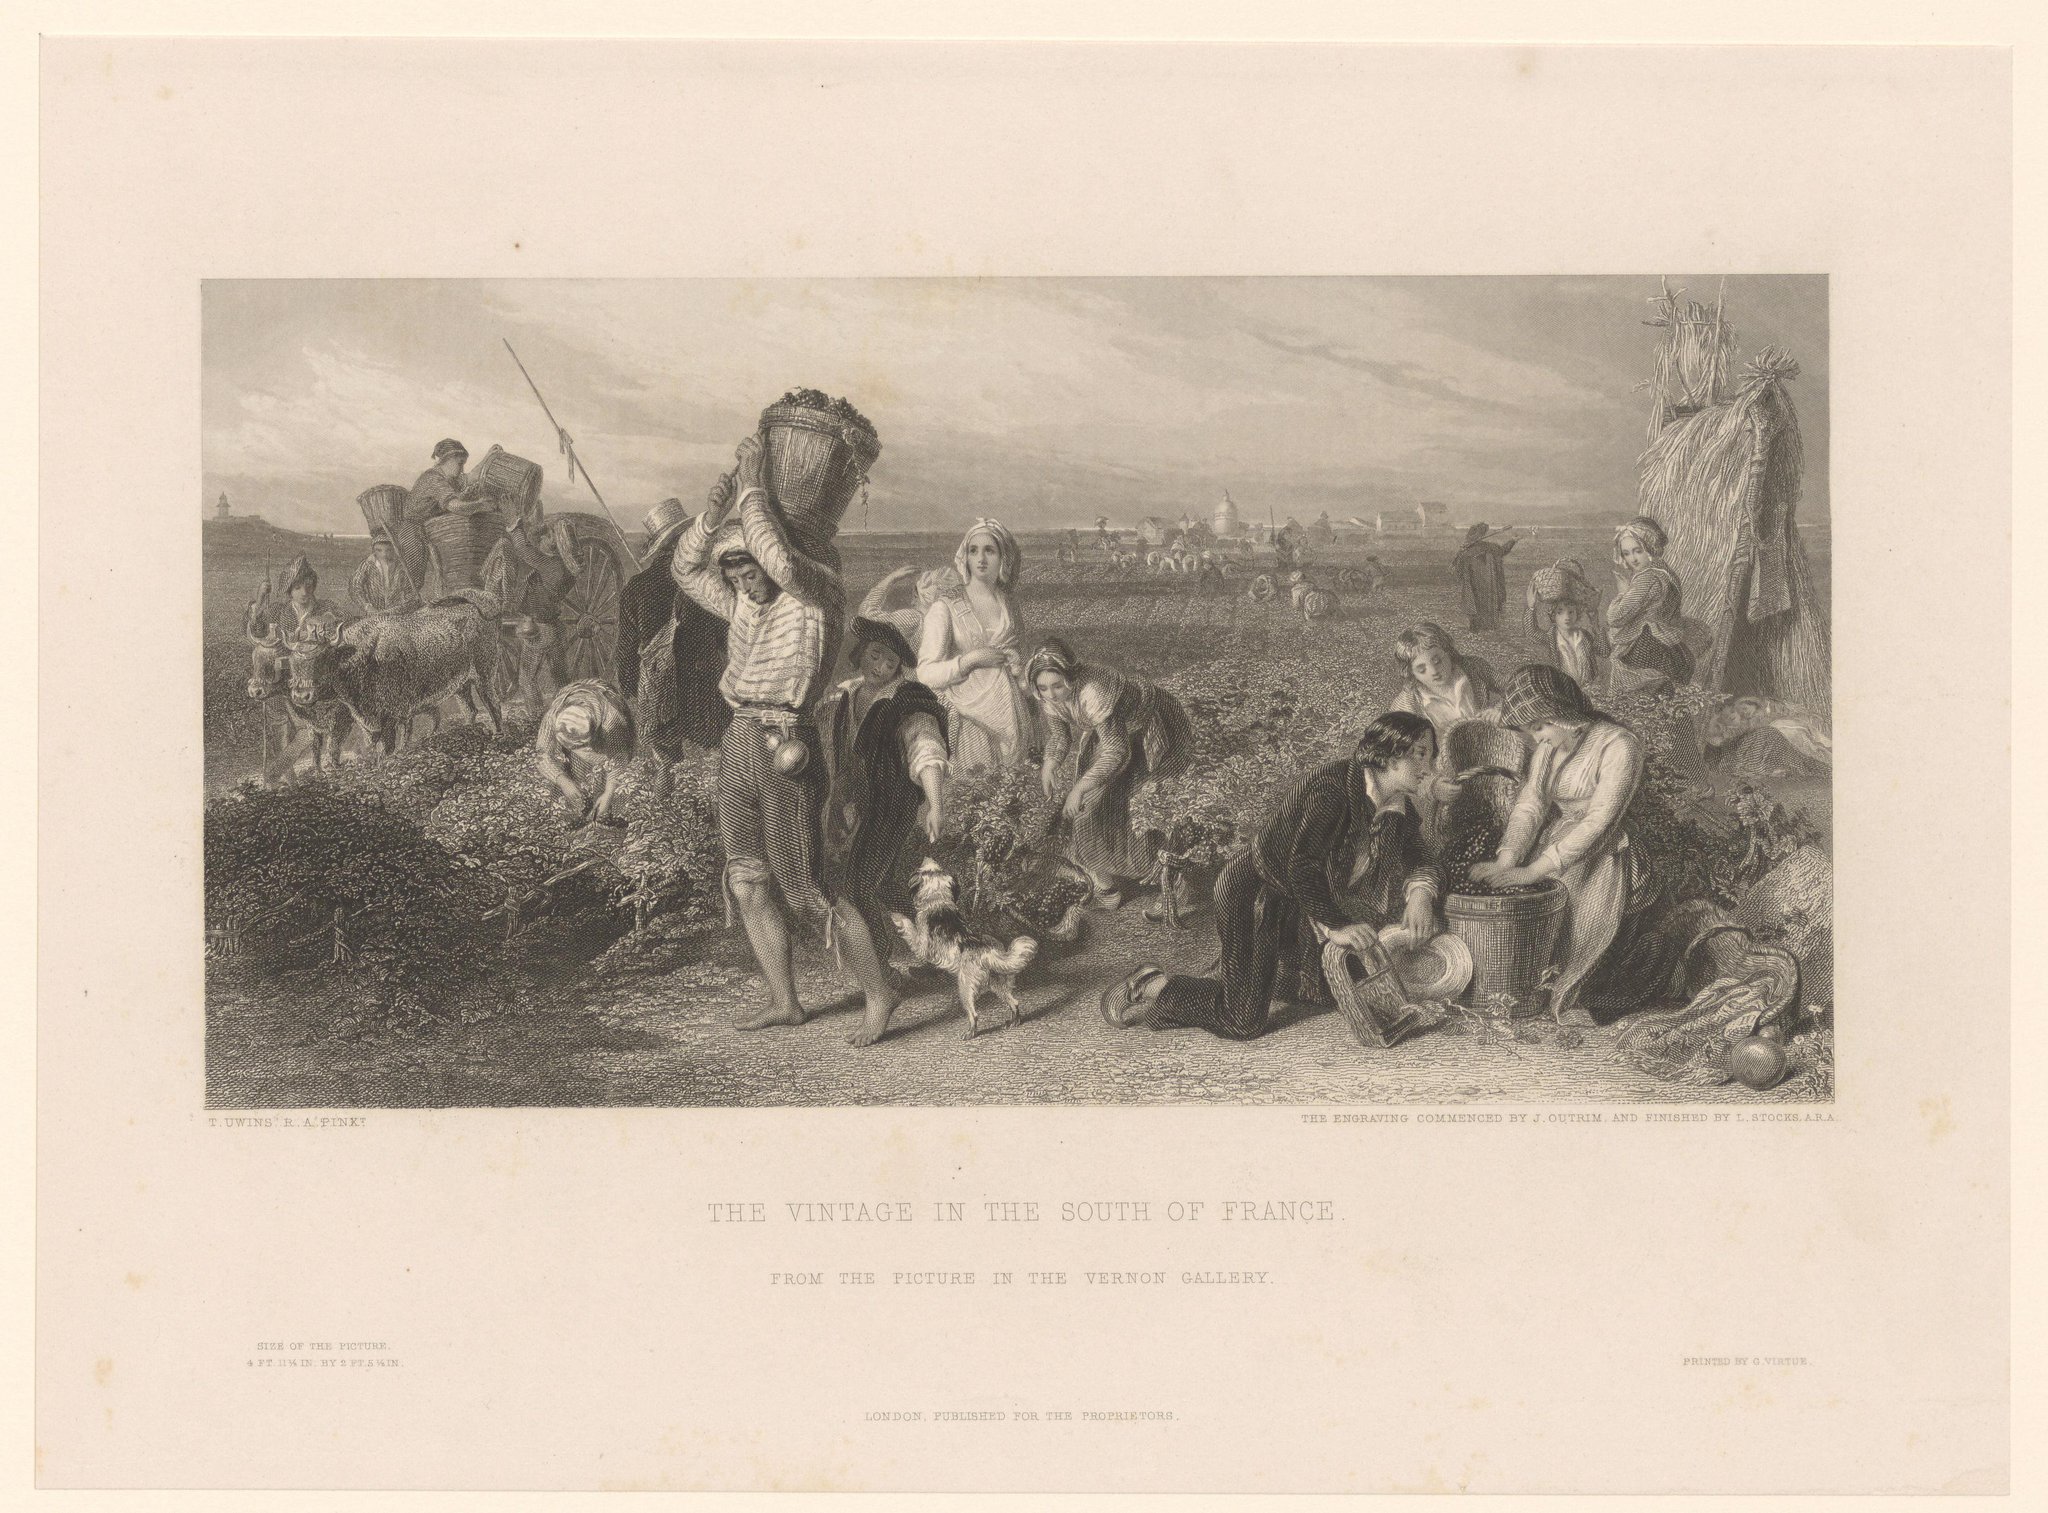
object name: book illustration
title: Mensen werken op een wijngaard in Zuid-Frankrijk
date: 1854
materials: paper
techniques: engraving, etching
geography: london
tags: vineyard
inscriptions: collector's mark: Lugt 2228